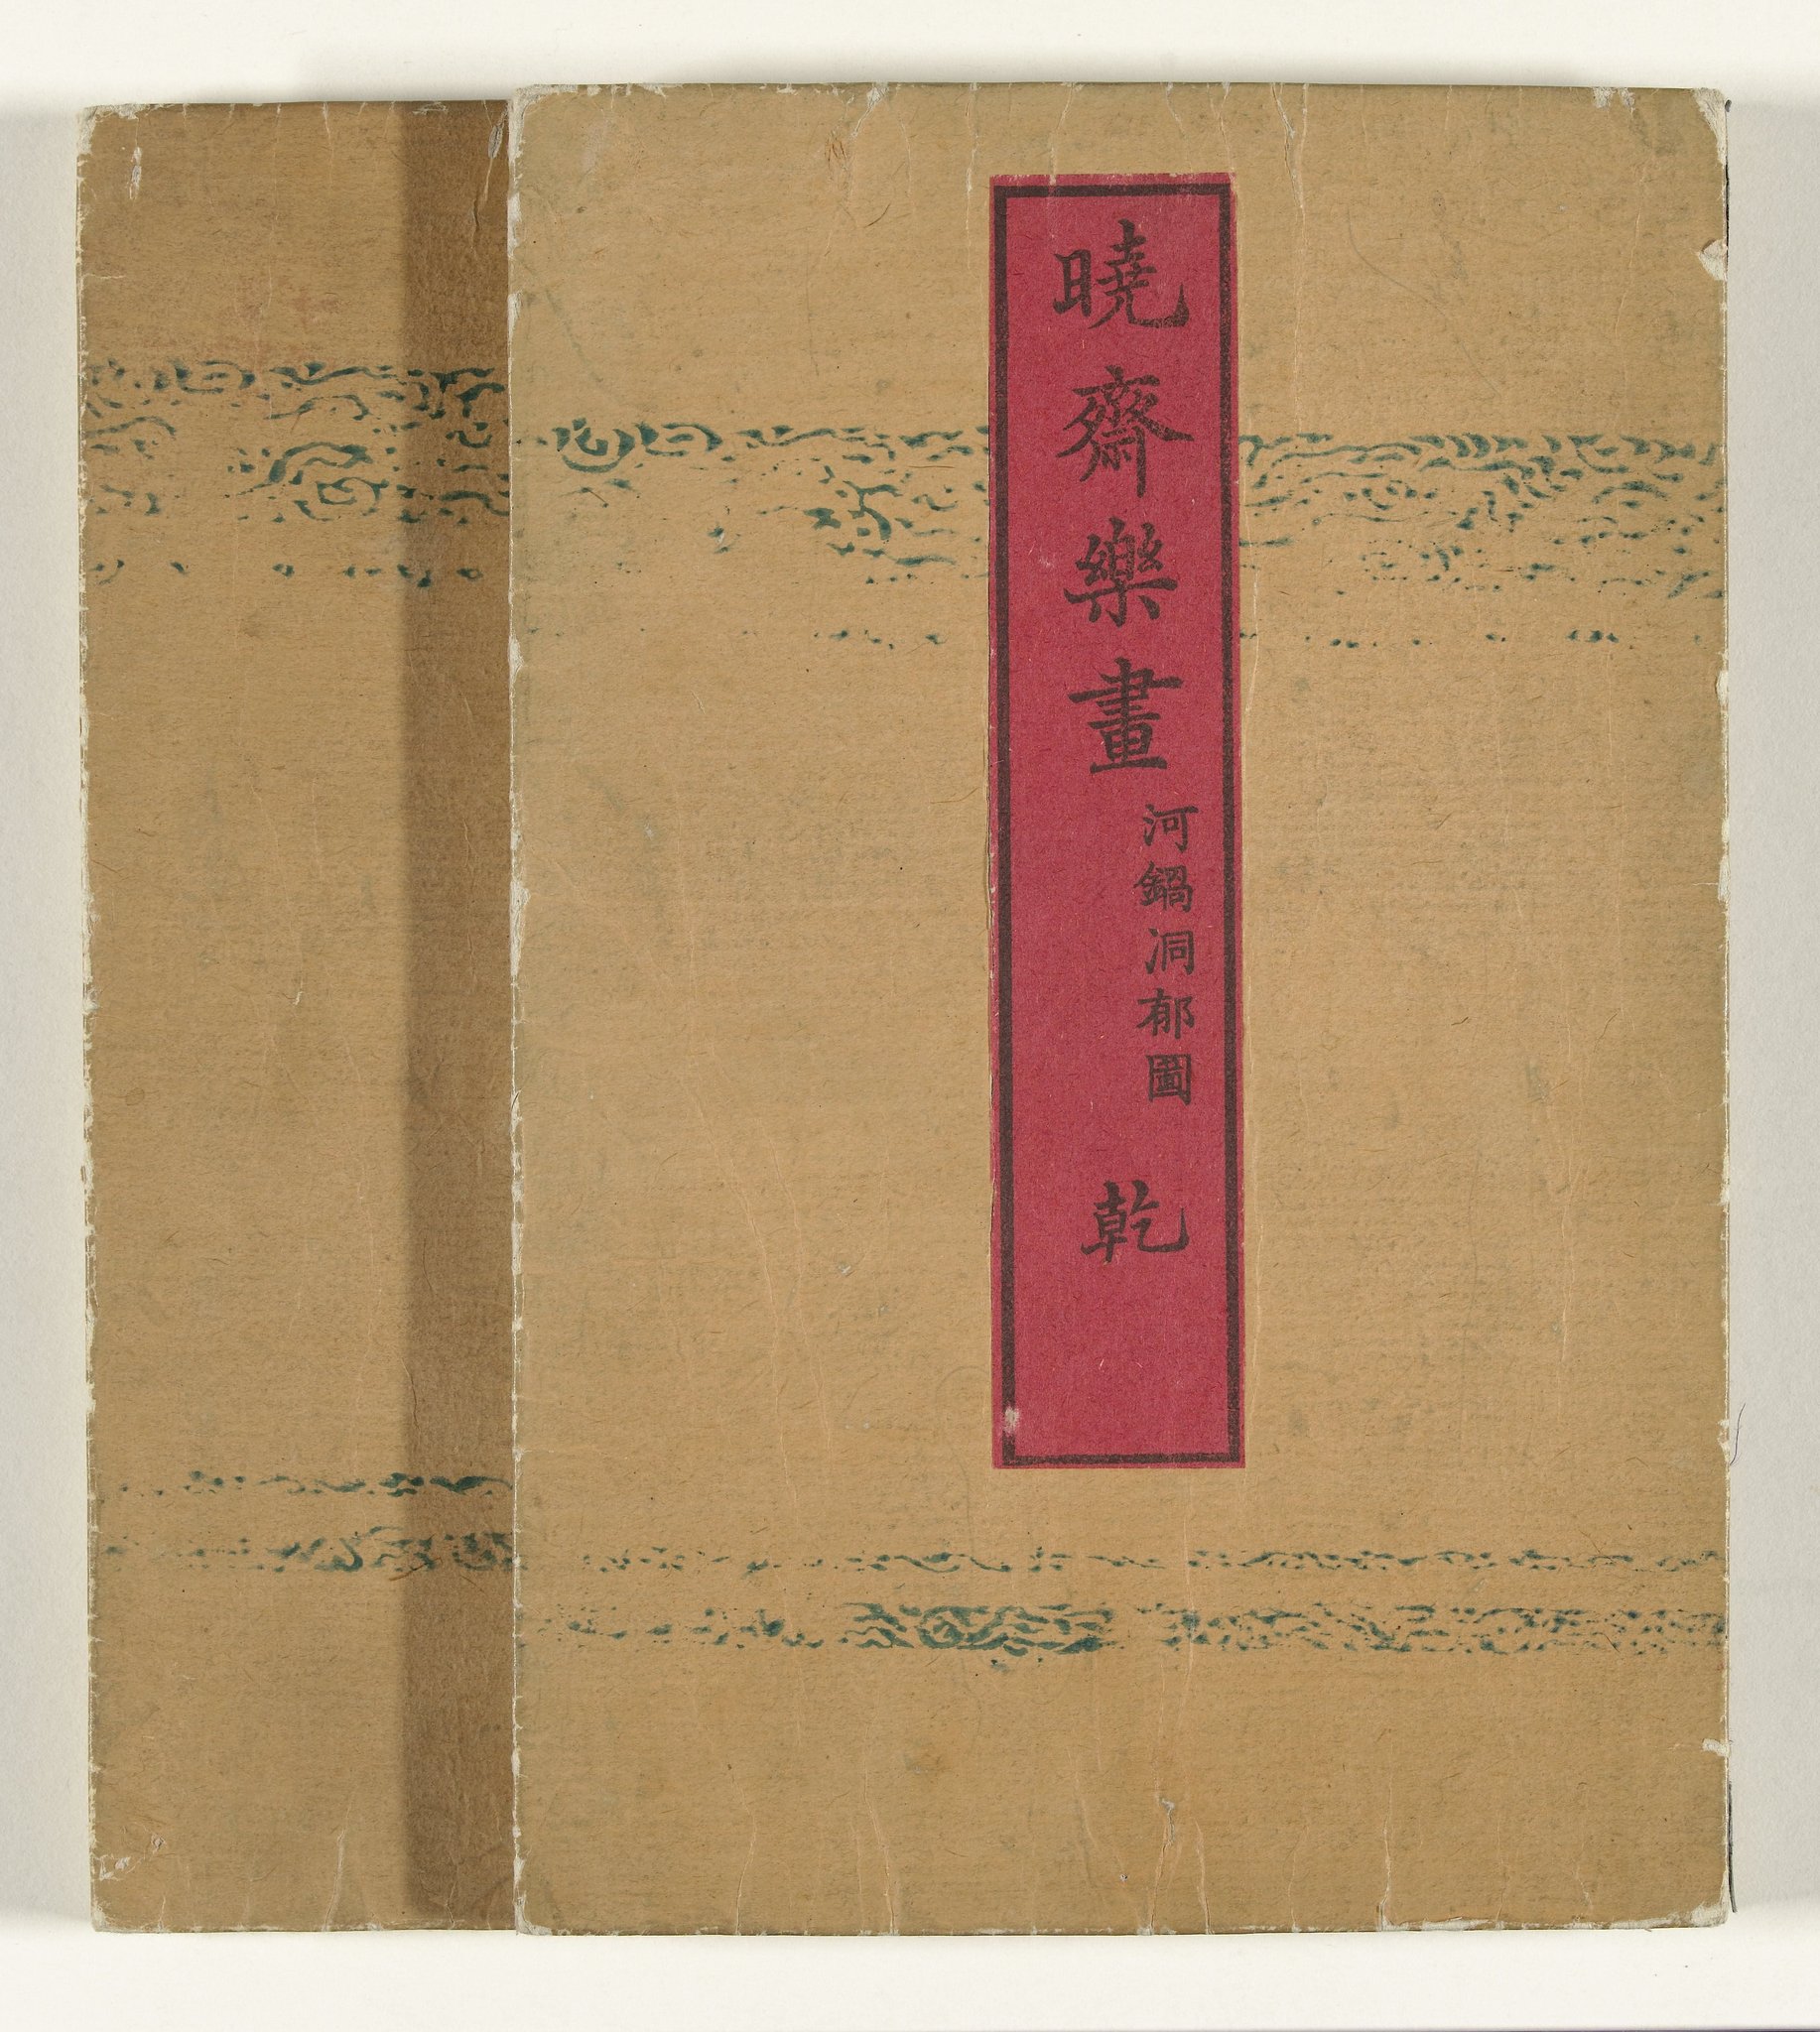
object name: book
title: Gyosai rakuga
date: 1881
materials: paper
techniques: woodcut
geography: tokyo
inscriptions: date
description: Twee delen (compleet), met natuurstudies van dieren en landschappen; in een rode chitsu (uitklapbaar doosje), met op de rug in goudkleurige letters: Kyosai Rakugwa 1880.